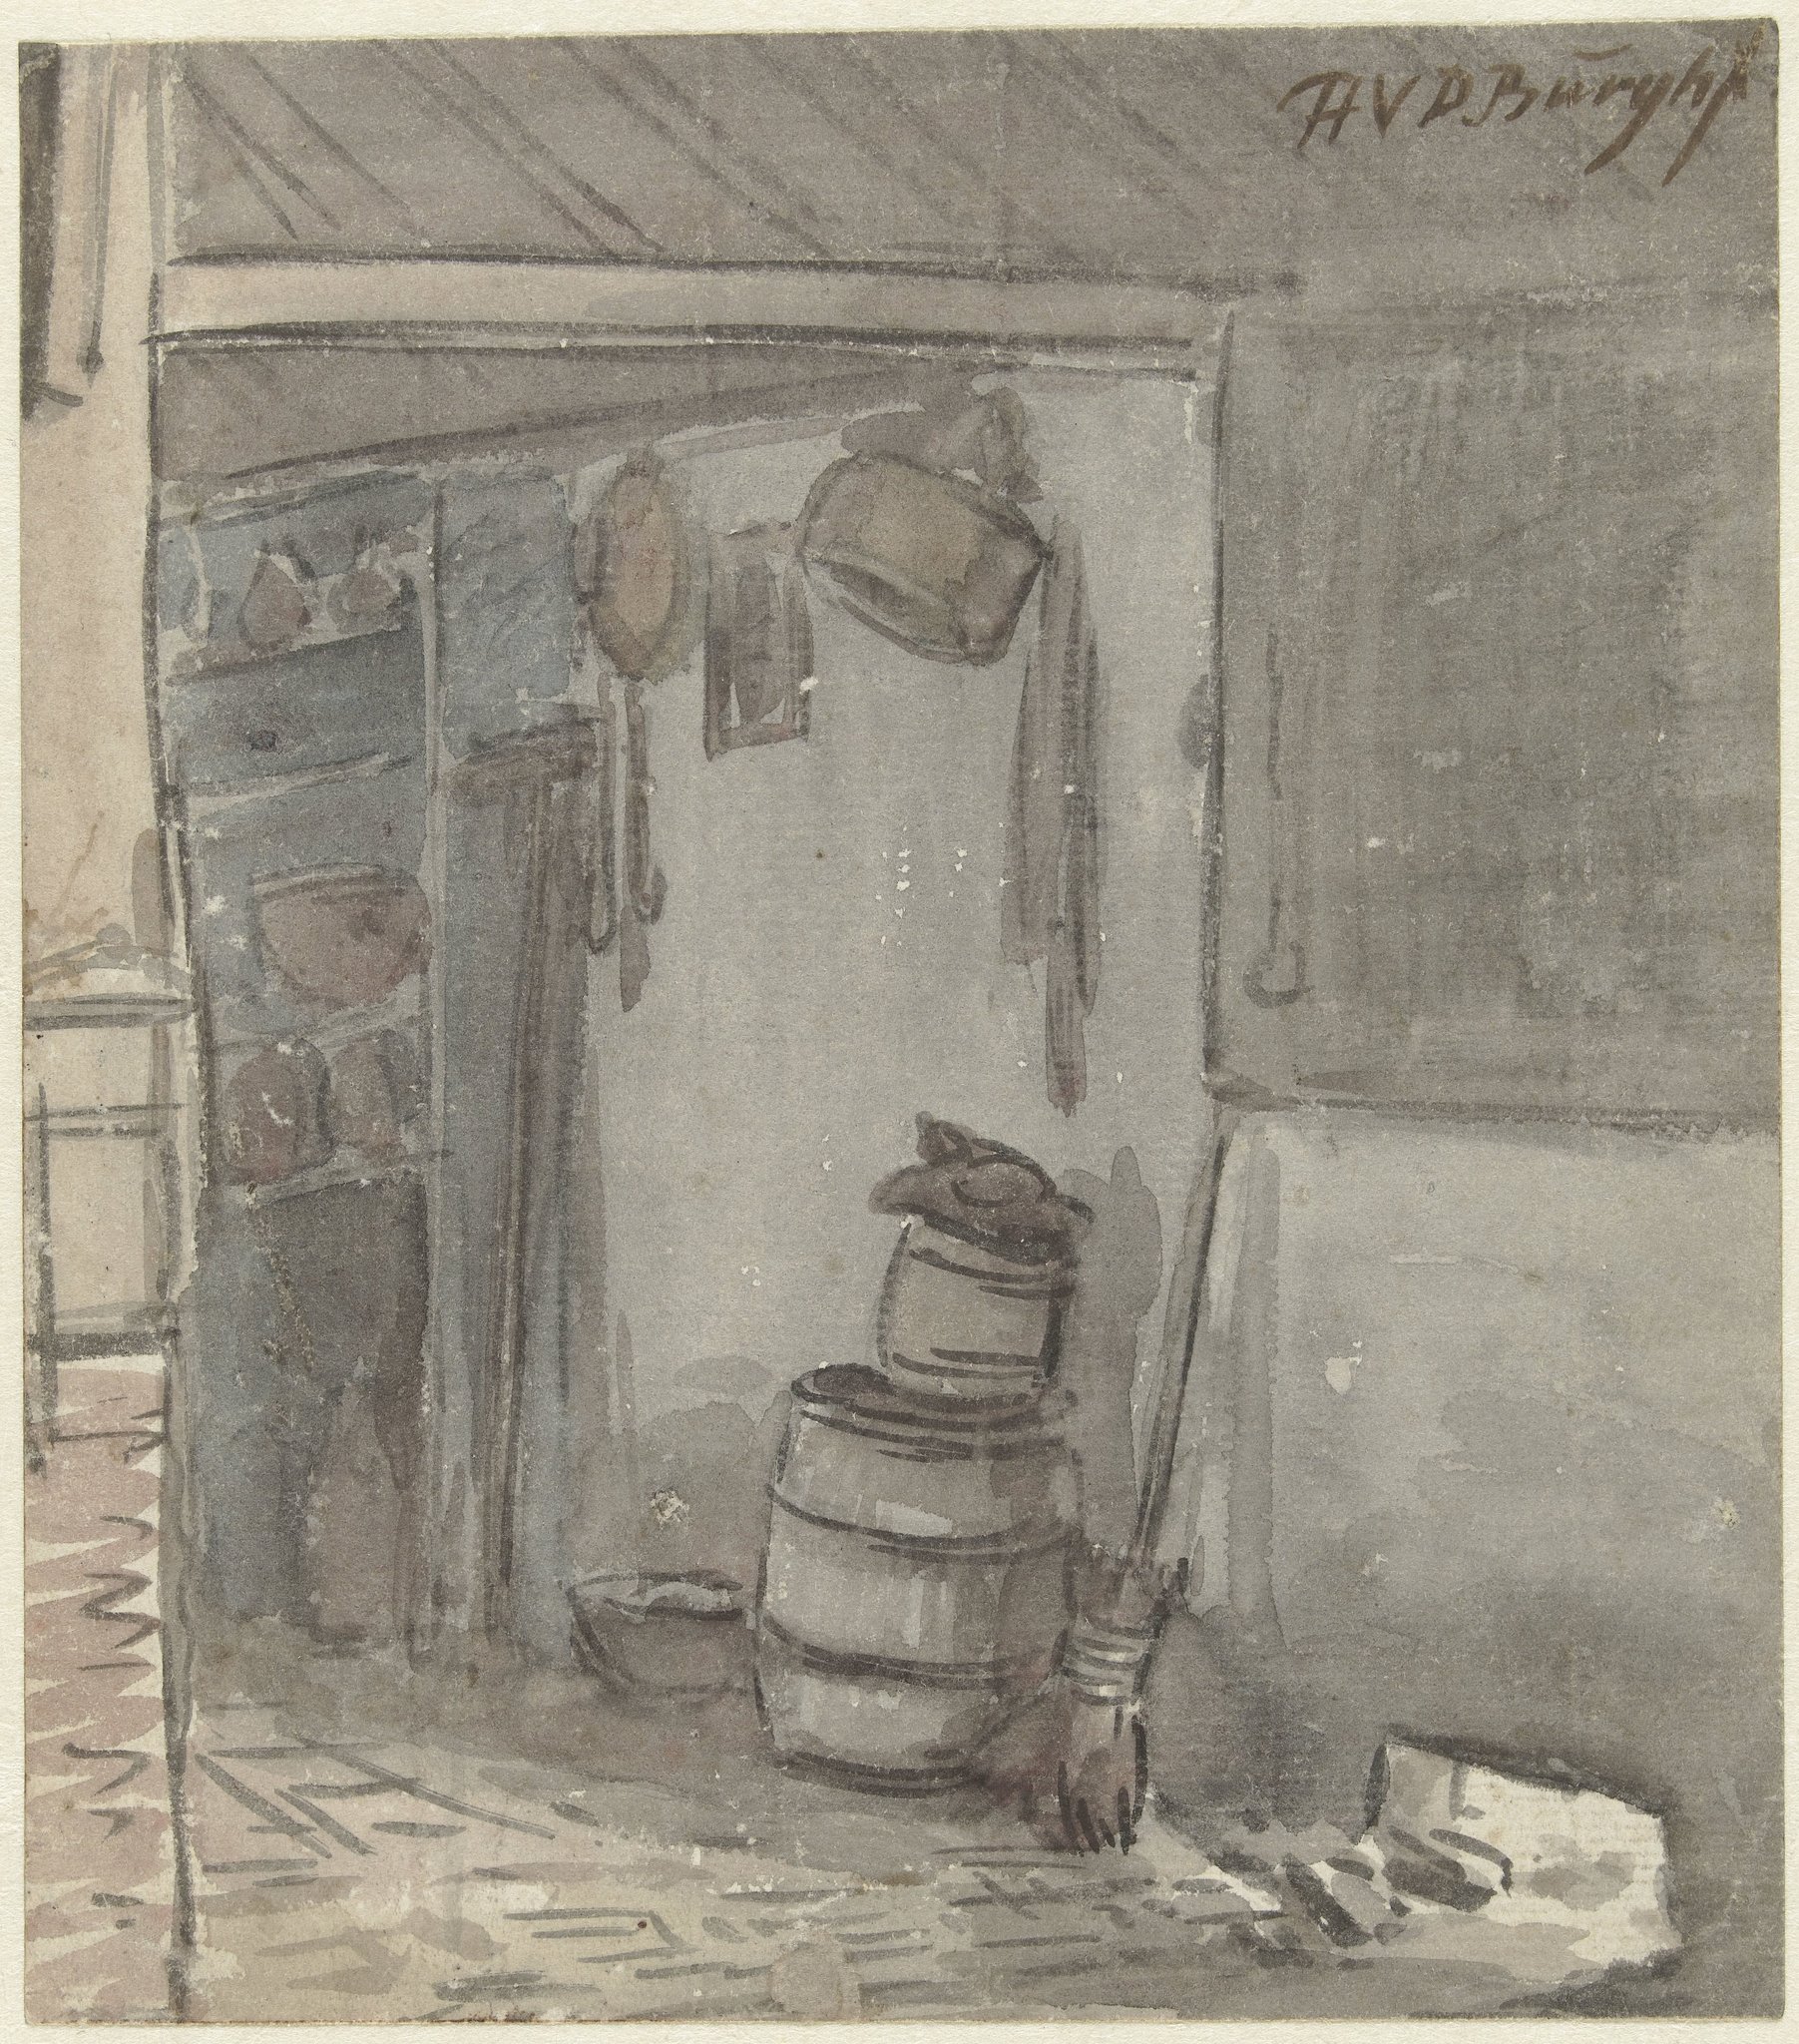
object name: watercolor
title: Gezicht in een boerendeel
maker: hendrik van der burgh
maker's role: draughtsman, print maker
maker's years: 1769-1858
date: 1779-1858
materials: paper, watercolor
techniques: brush